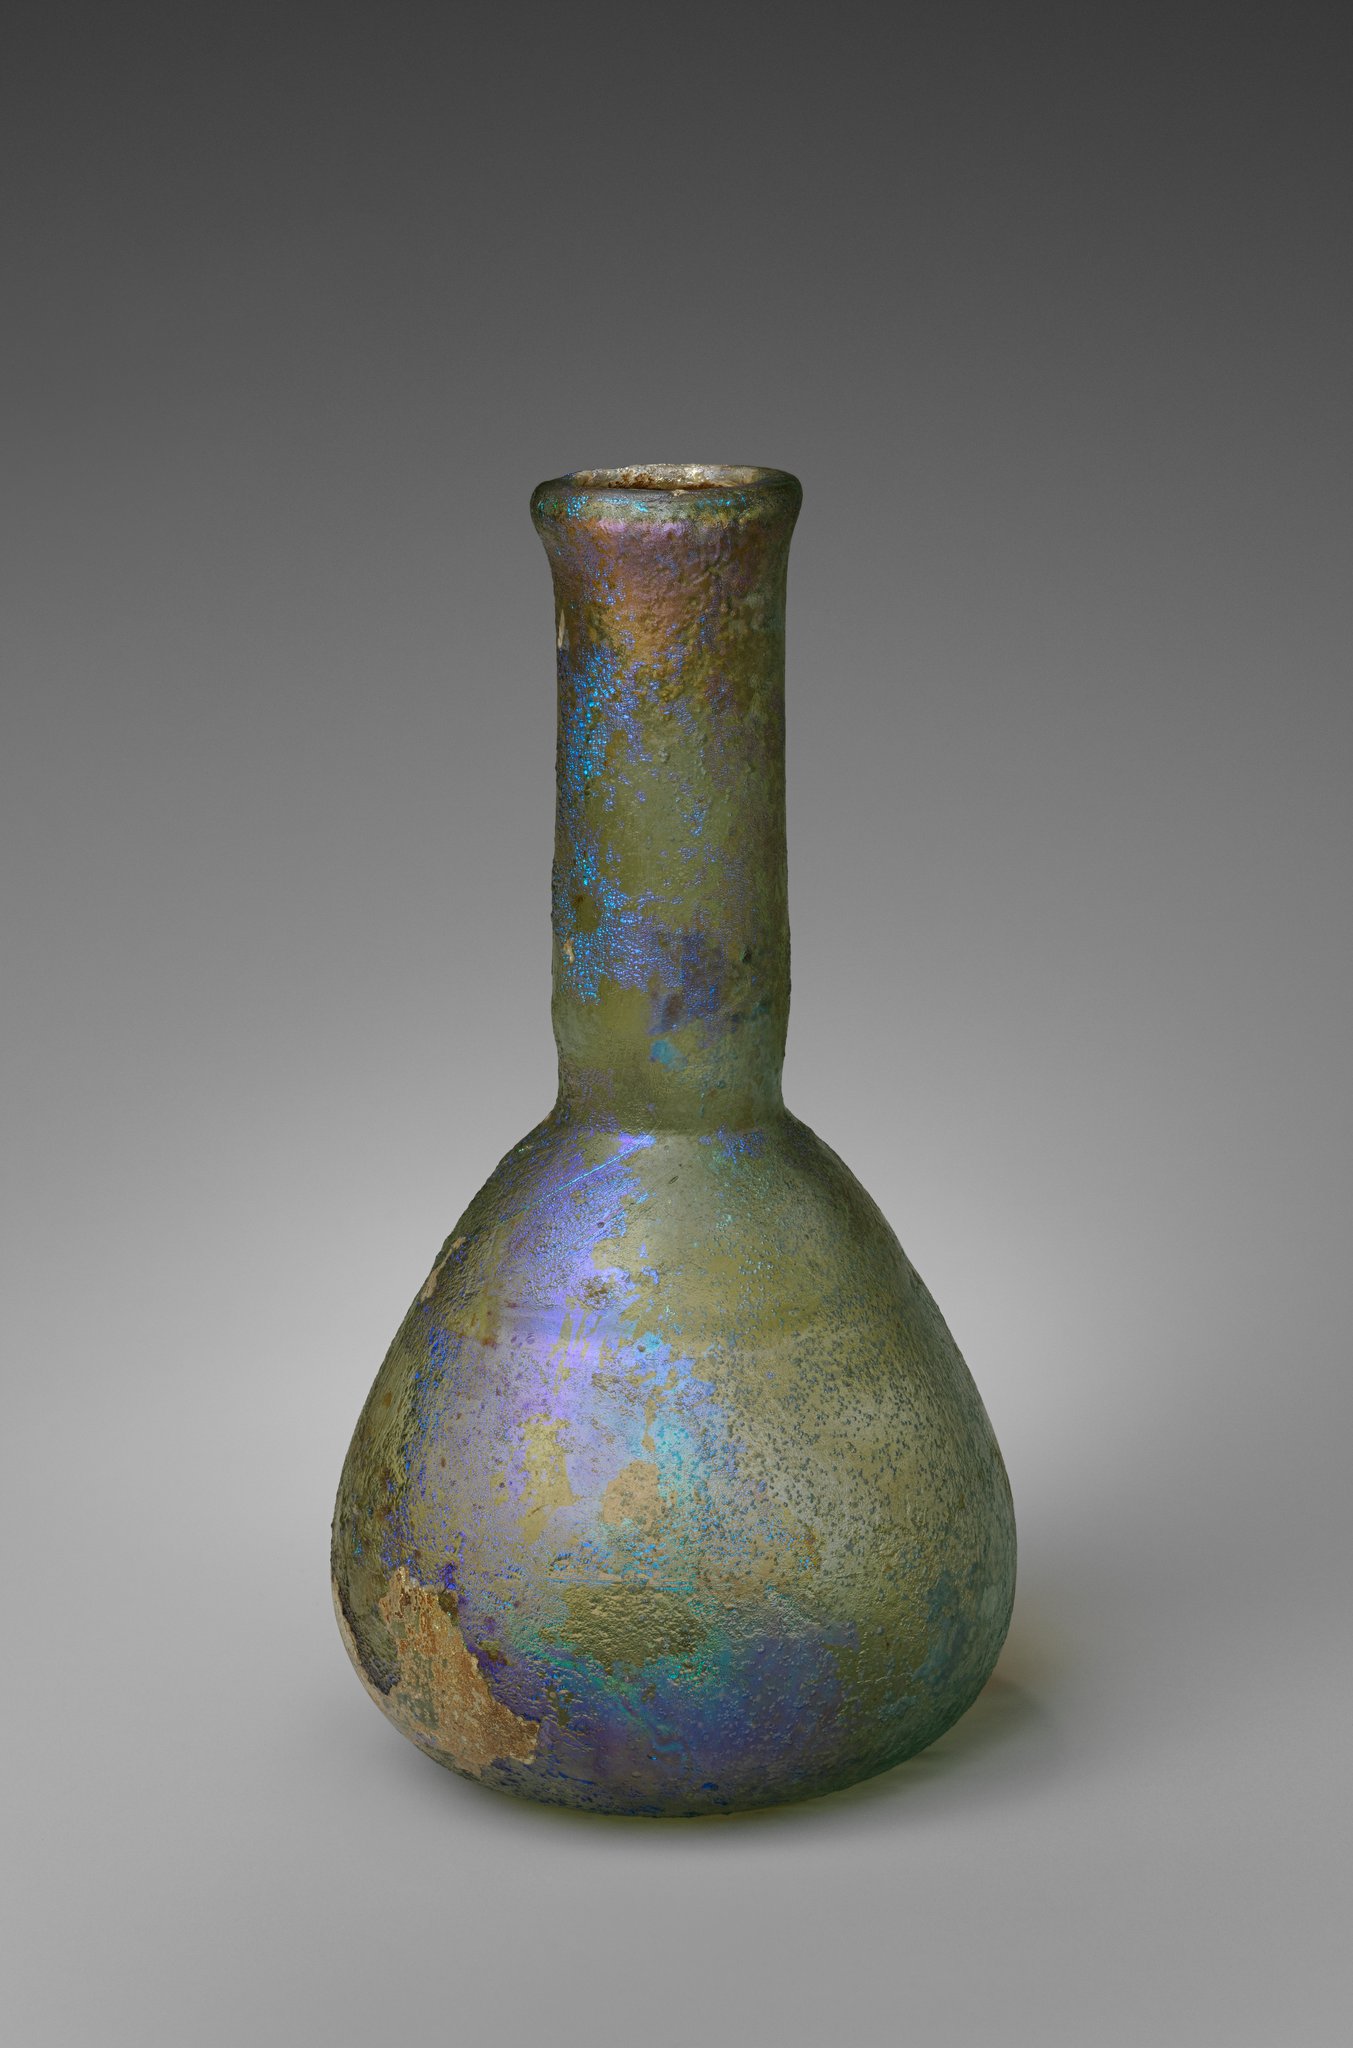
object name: perfume bottle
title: Glass perfume bottle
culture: roman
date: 1-200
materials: glass